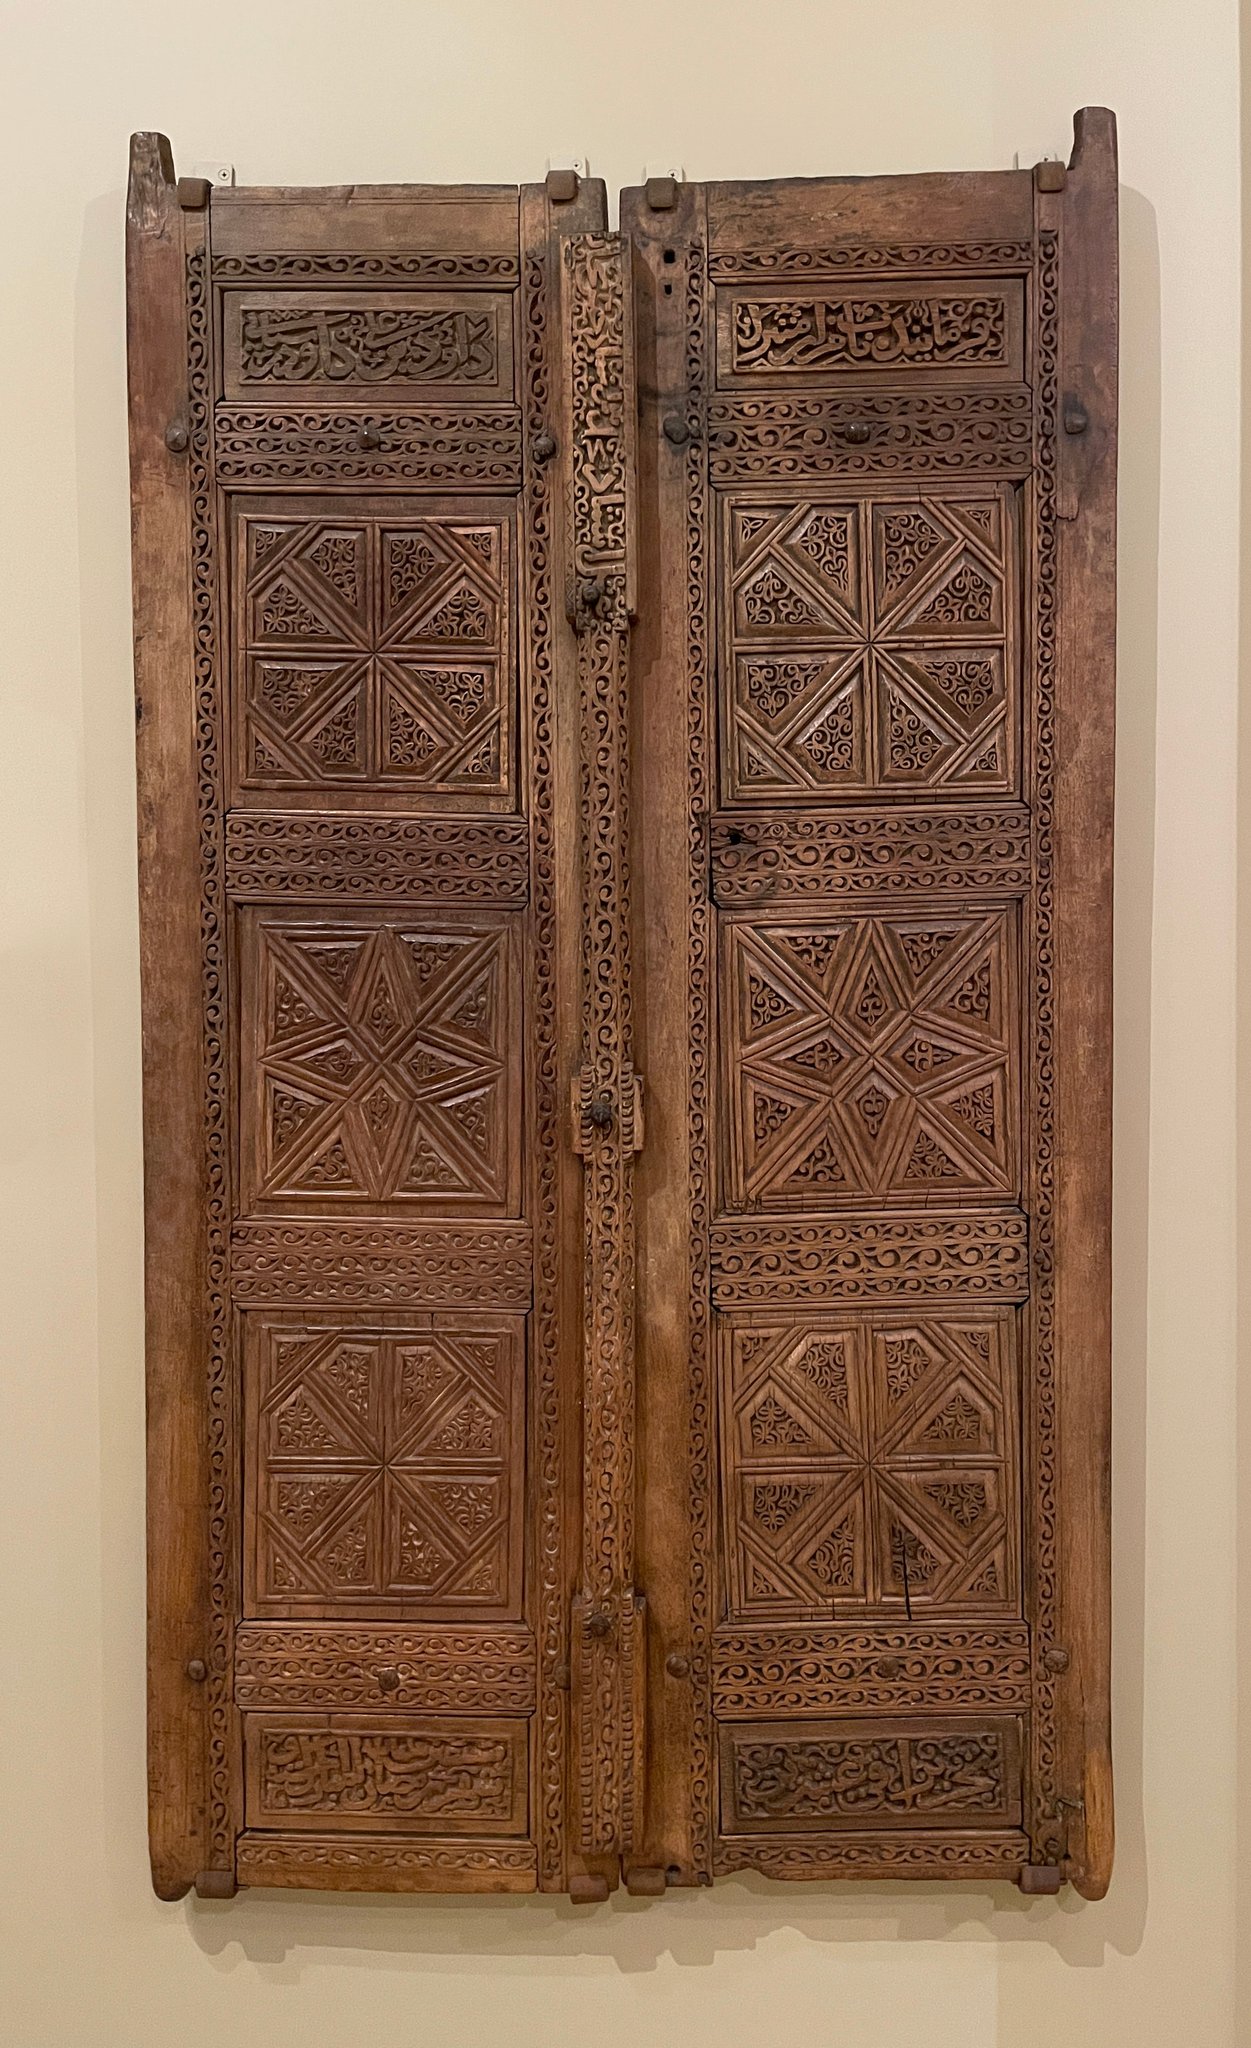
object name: door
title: Pair of Carved Doors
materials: wood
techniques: carving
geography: iran